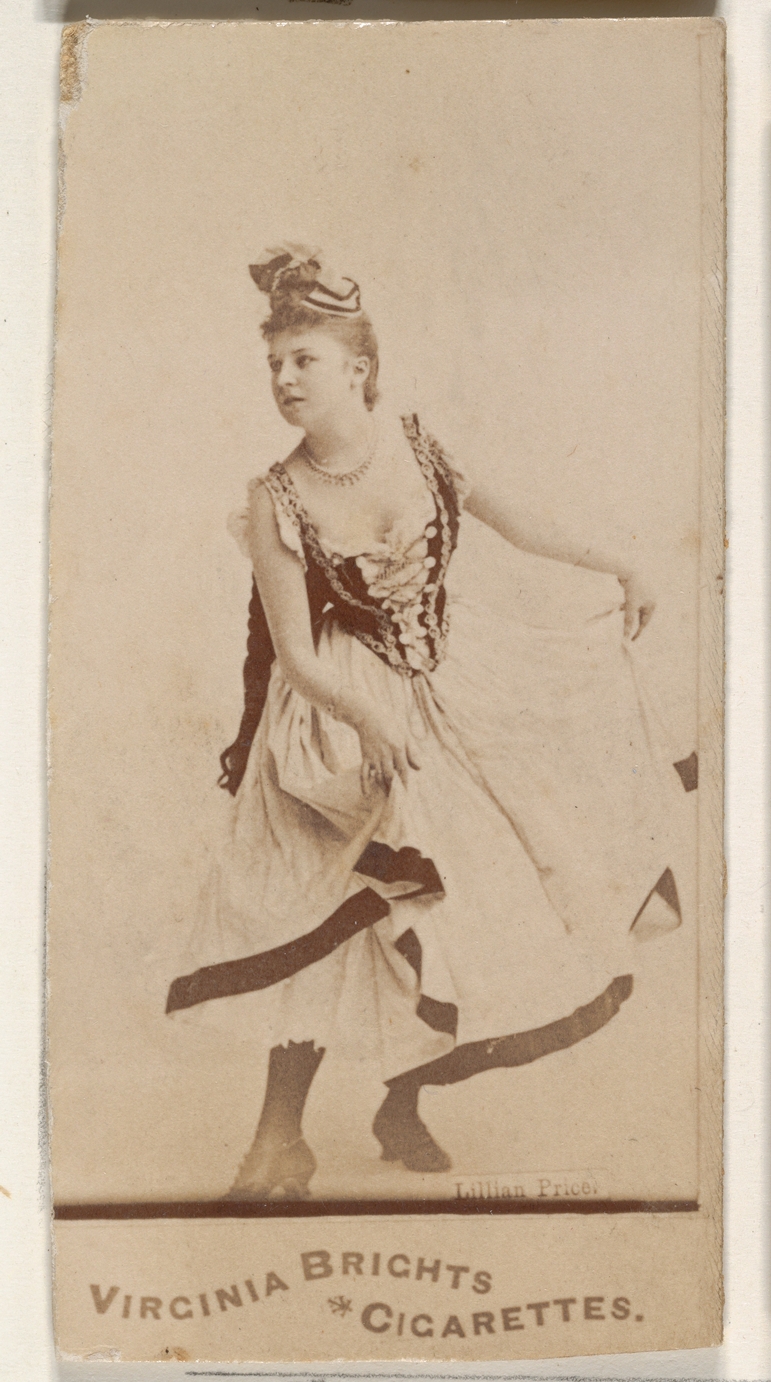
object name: photograph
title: Lillian Price, from the Actors and Actresses series (N45, Type 1) for Virginia Brights Cigarettes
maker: allen & ginter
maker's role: publisher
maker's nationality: american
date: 1888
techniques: albumen silver print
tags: portraits,women,dancing,actresses